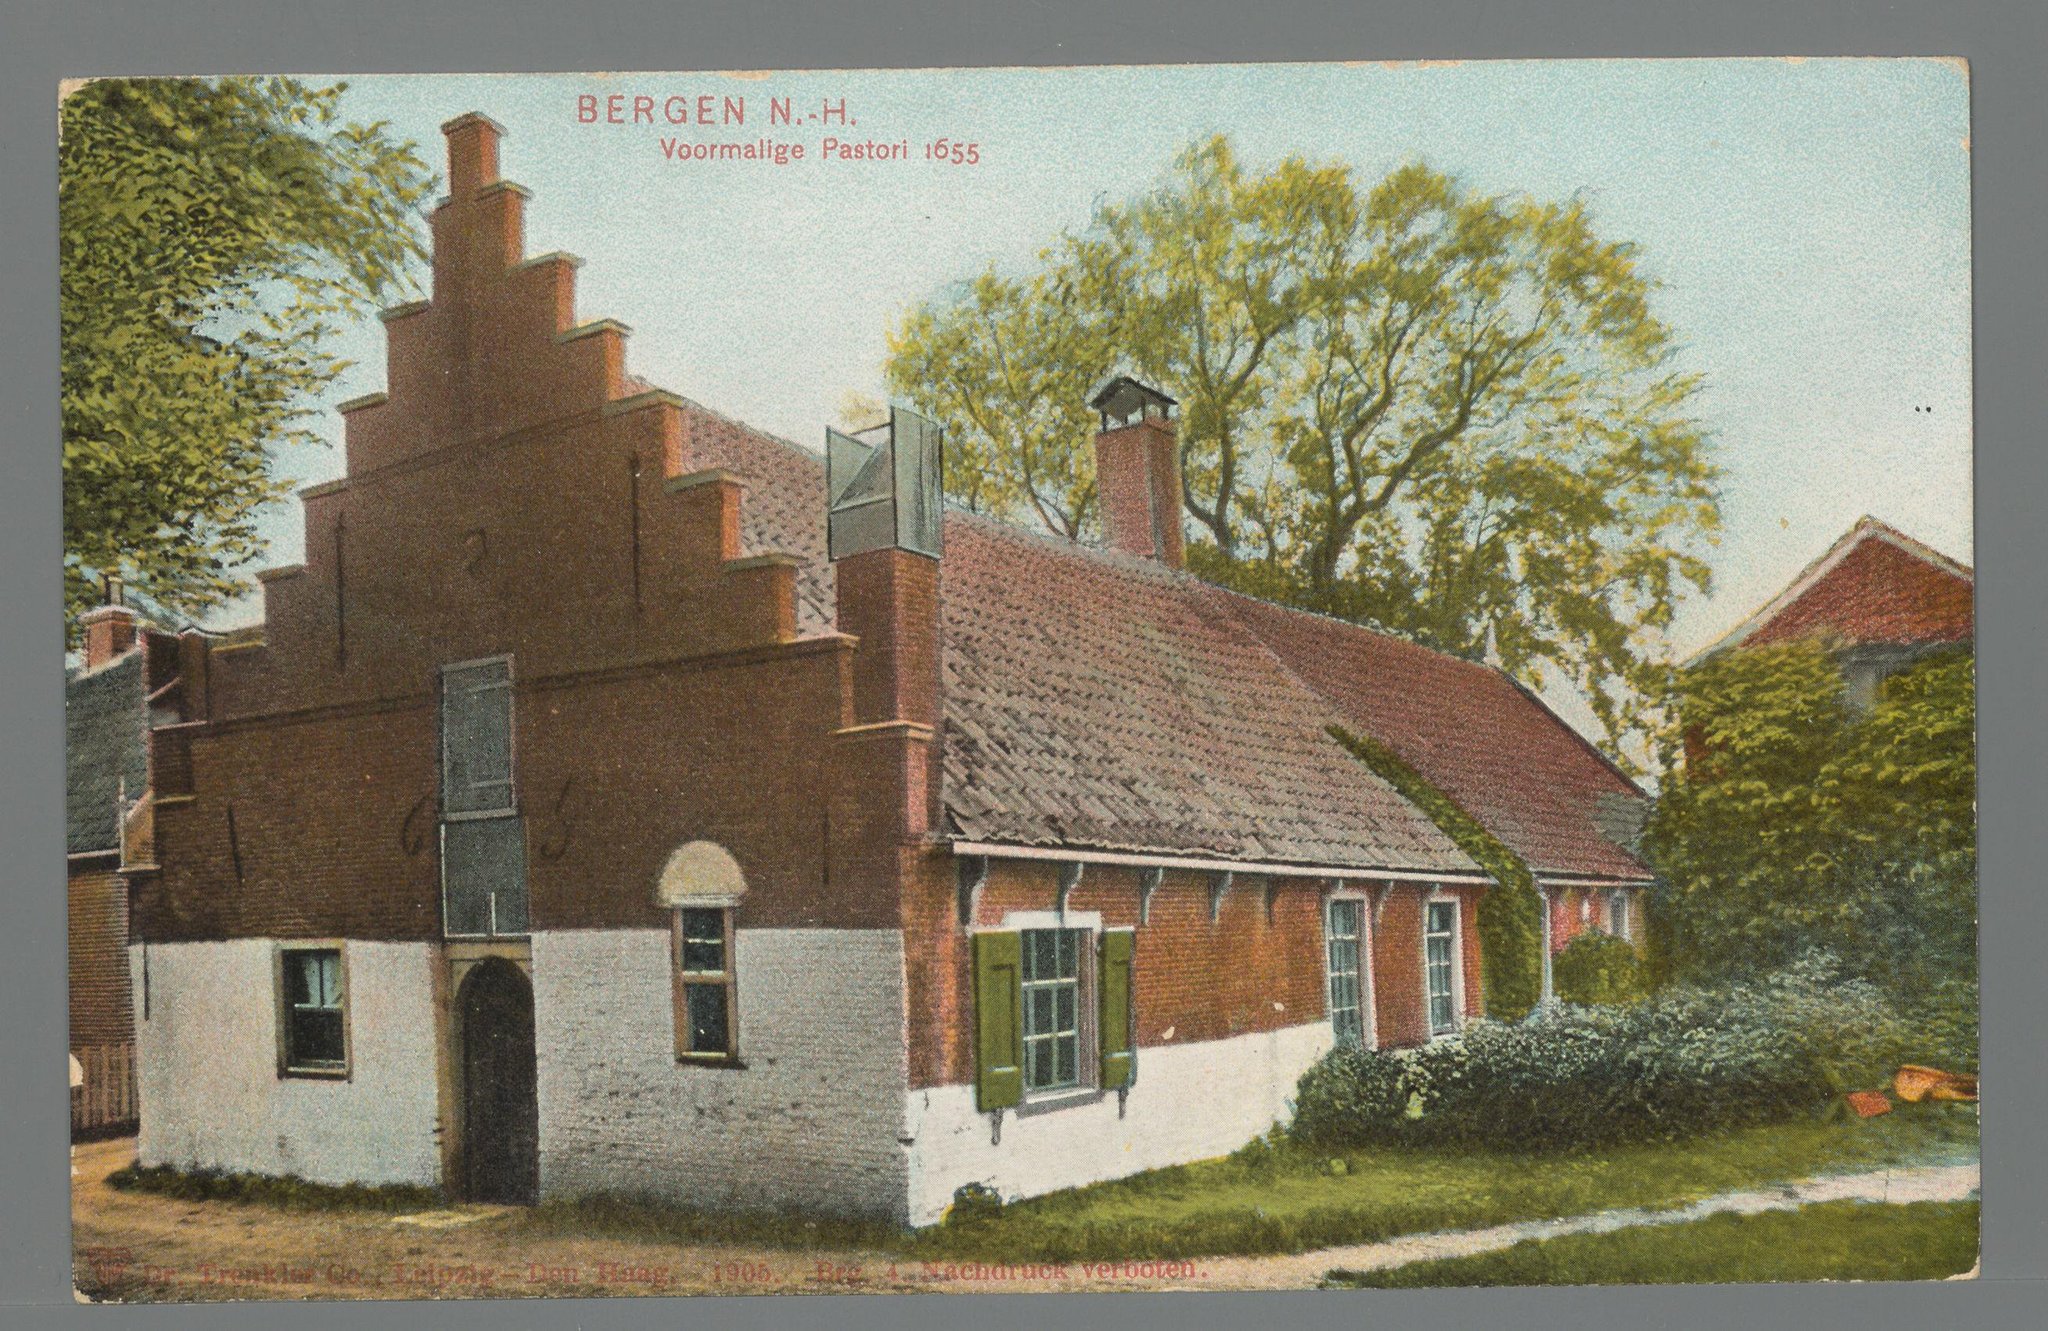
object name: ansichtkaart, prentbriefkaart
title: Bergen N.-H. Voormalige Pastori 1655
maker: Anonymous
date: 1905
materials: cardboard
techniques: lithograph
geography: leipzig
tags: urban housing